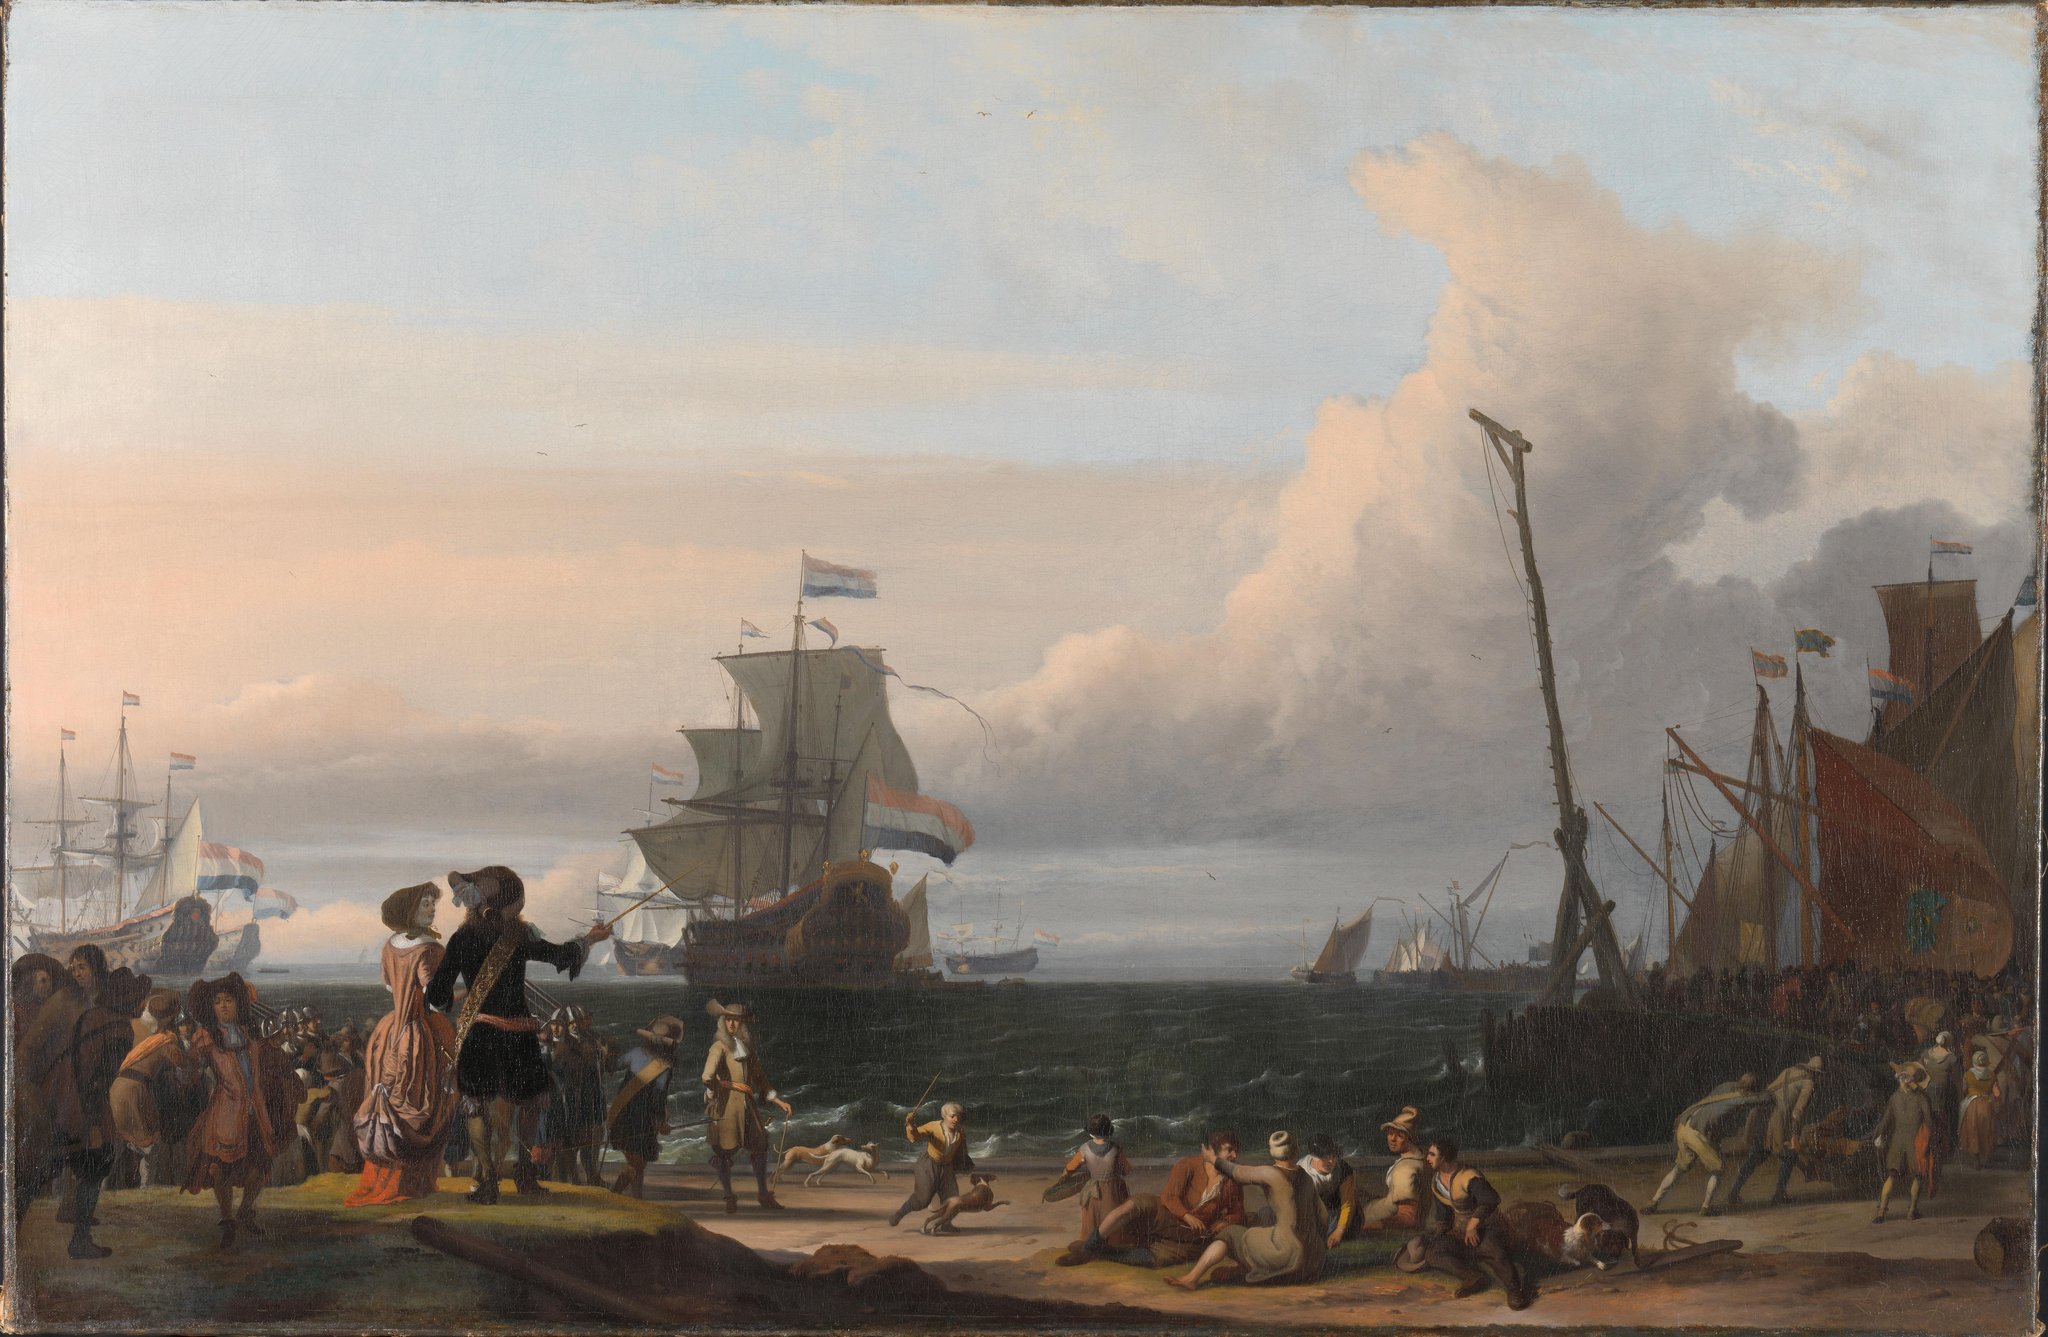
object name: painting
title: Dutch Ships in the Roads of Texel; in the middle the 'Gouden Leeuw', the Flagship of Cornelis Tromp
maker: ludolf bakhuysen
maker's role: draughtsman, print maker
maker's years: 1631-1708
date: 1671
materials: canvas, oil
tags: harbour, straits, narrows, sailing-ship, sailing-boat, pier, quay, wharf, ship in the roads, roadstead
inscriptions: signature and date: ‘L. Bakh. 1671’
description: Marines embarking on the Texel roads by Ludolf Bakhuysen, 1671. Large ships sailed from the harbours of the Zuiderzee to Texel with a minimal crew and provisions. At Texel they took on water and victuals, and here the sailors, soldiers and officers embarked. A unit of marines led by their commander on the beach is marching towards the harbour pier. Boats are ready to ferry them to the warships. A high-ranking officer and his wife are watching the activity from a low dune. He is wearing a gold-embroidered sash with sword and is pointing out the ships lying at anchor with his walkingstick. In 1665 Baron Joseph van Gendt was given command of the marine company. Perhaps this is the man with the walkingstick.